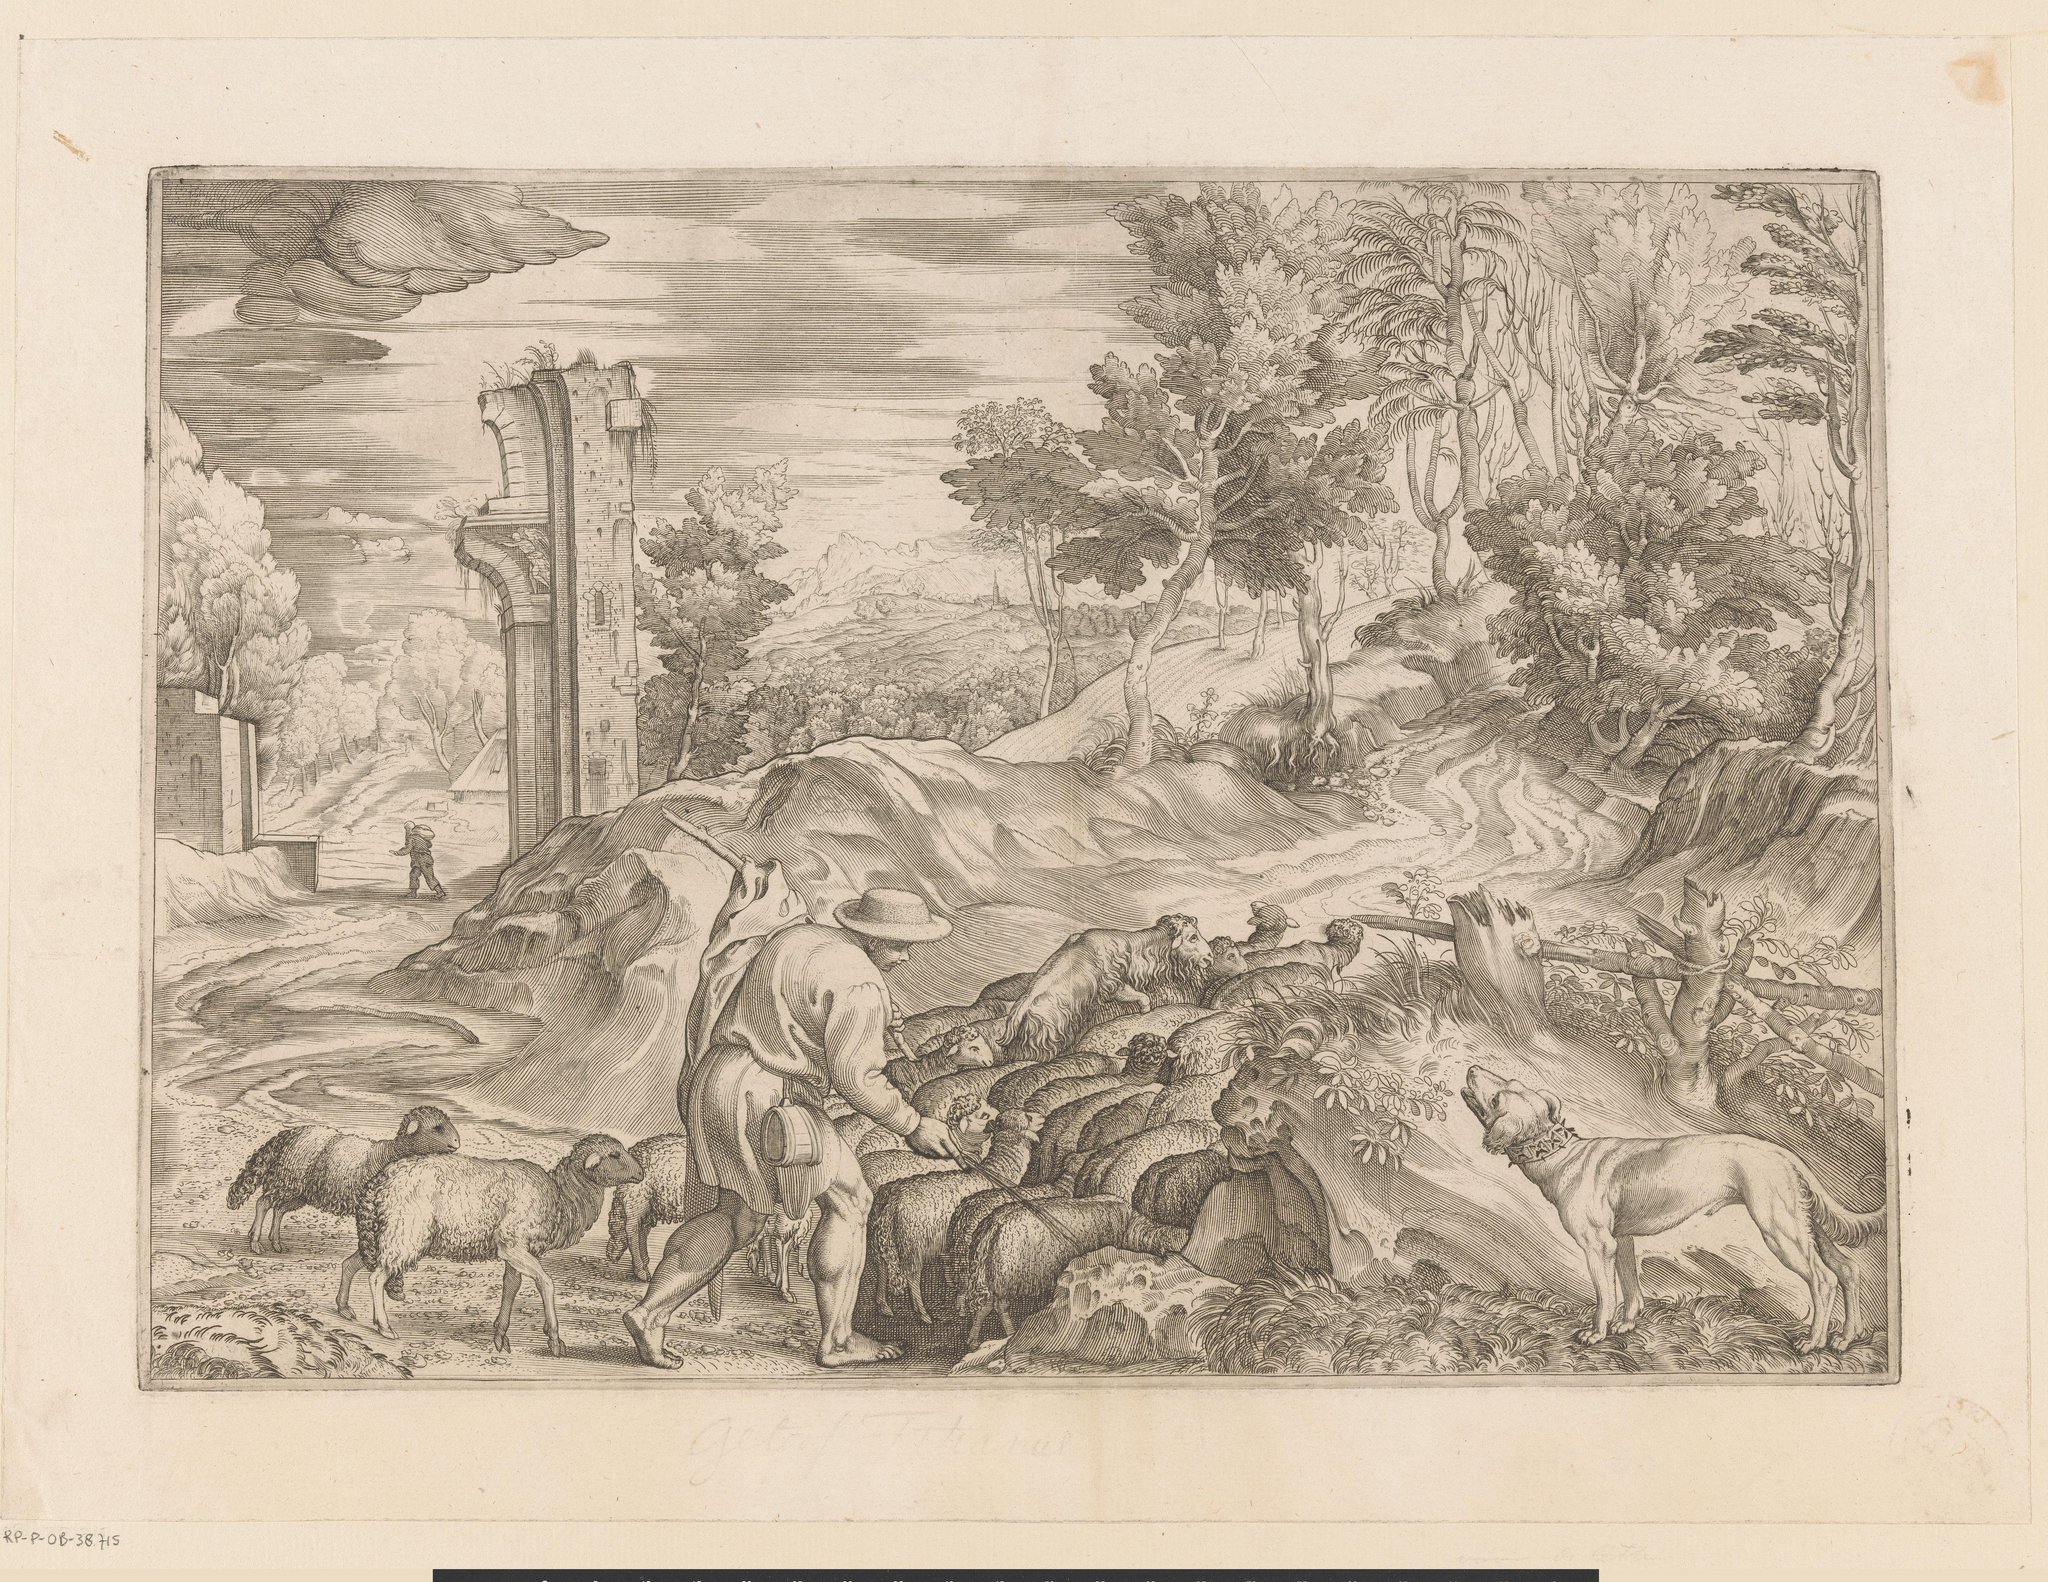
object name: print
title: Herder met kudde schapen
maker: Anonymous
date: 1498-1626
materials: paper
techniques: engraving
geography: italy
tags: landscape with ruins, herd, flock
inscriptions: collector's mark: Lugt 240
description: Een jonge herder met zomerhoed leidt zijn kudde schapen op een heuvel. Zijn hond kijkt toe op de voorgrond rechts. Op de achtergrond rechts een bosrijke heuvel en links een antieke ruïne en een wandelaar.